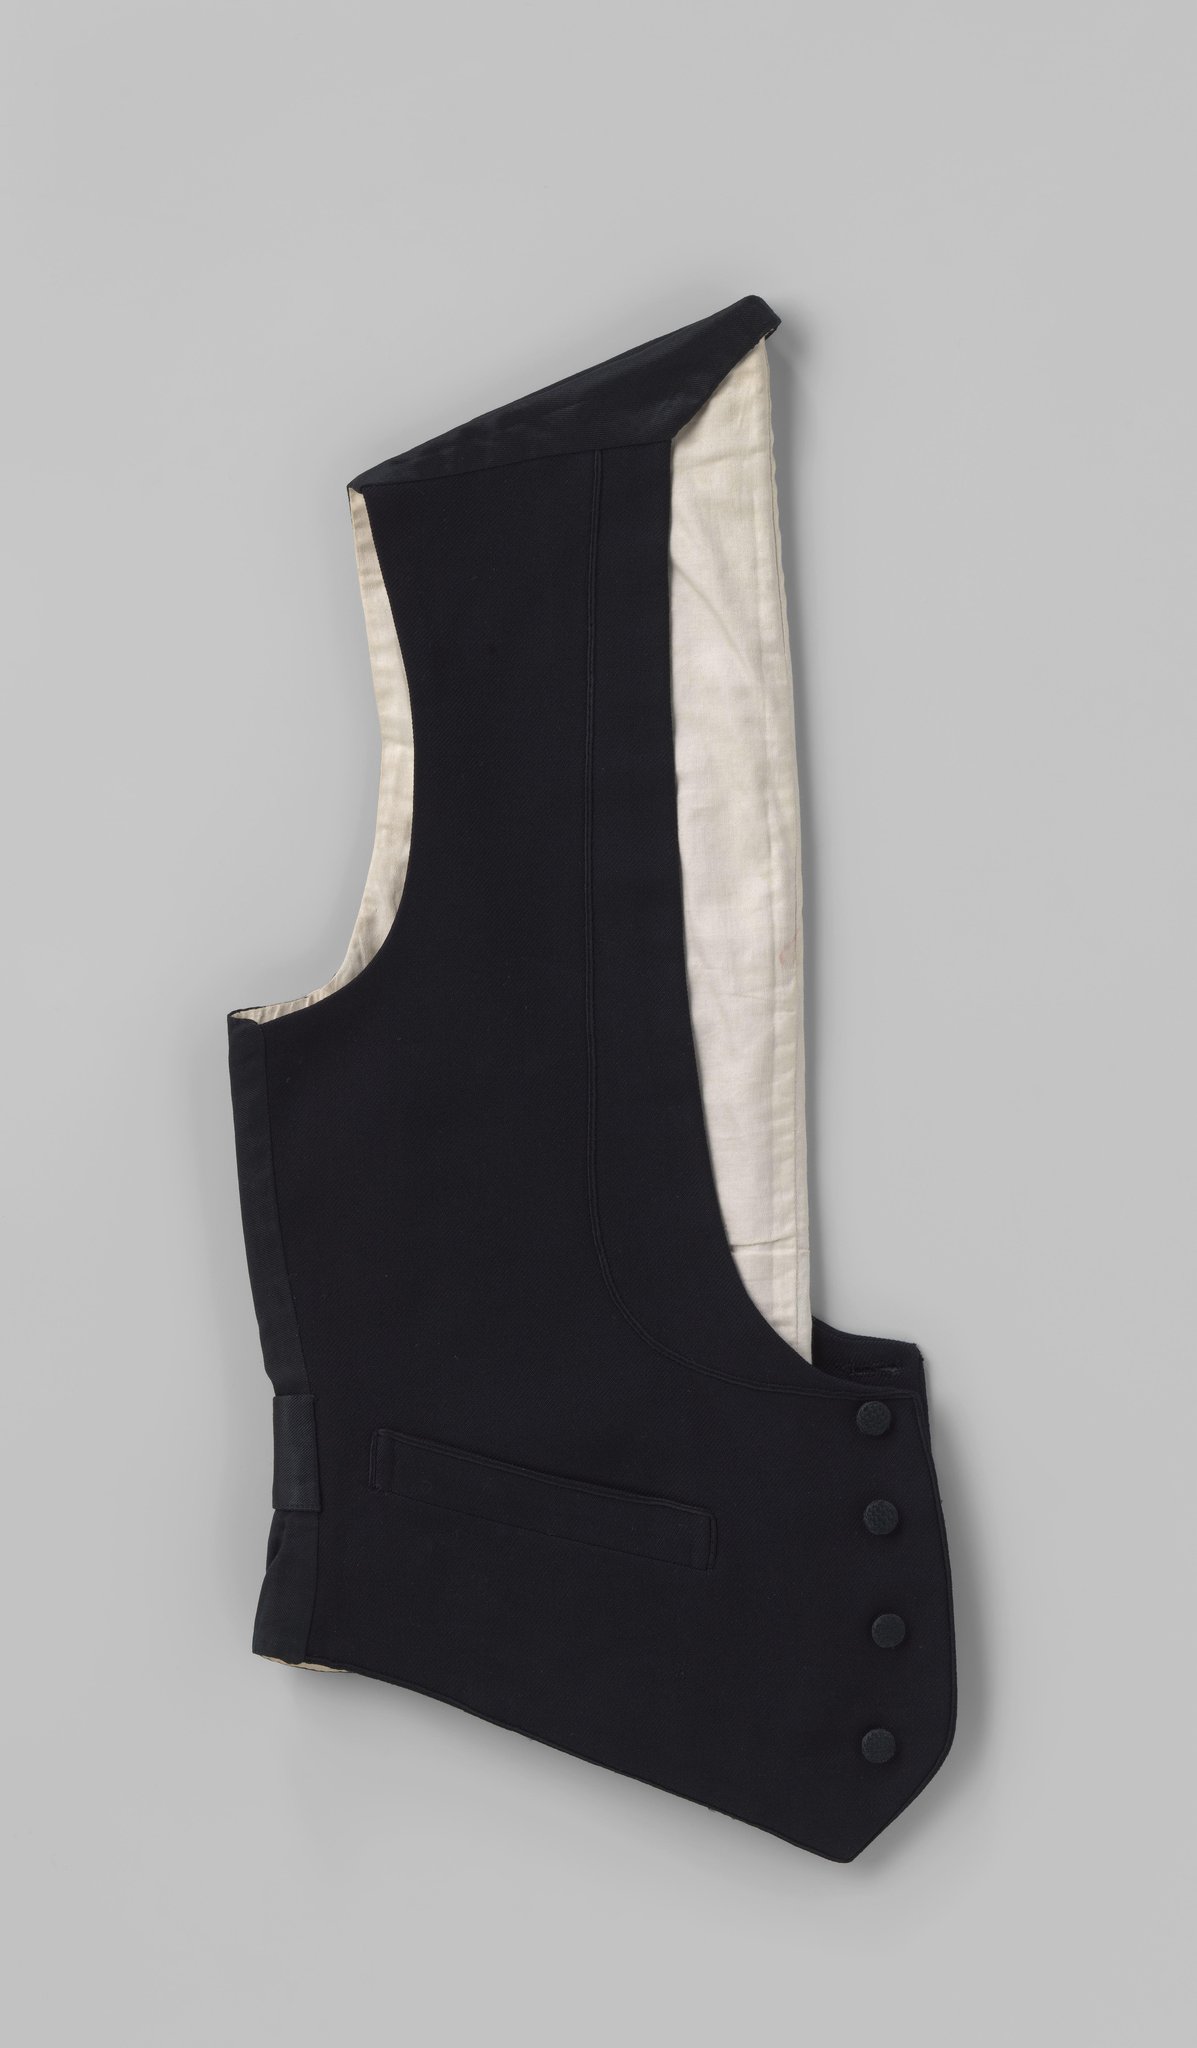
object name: rokvest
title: Vest met diepe afgeronde hals met ronde kraag van zwarte wol met soutache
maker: Anonymous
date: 1930-1940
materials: wool